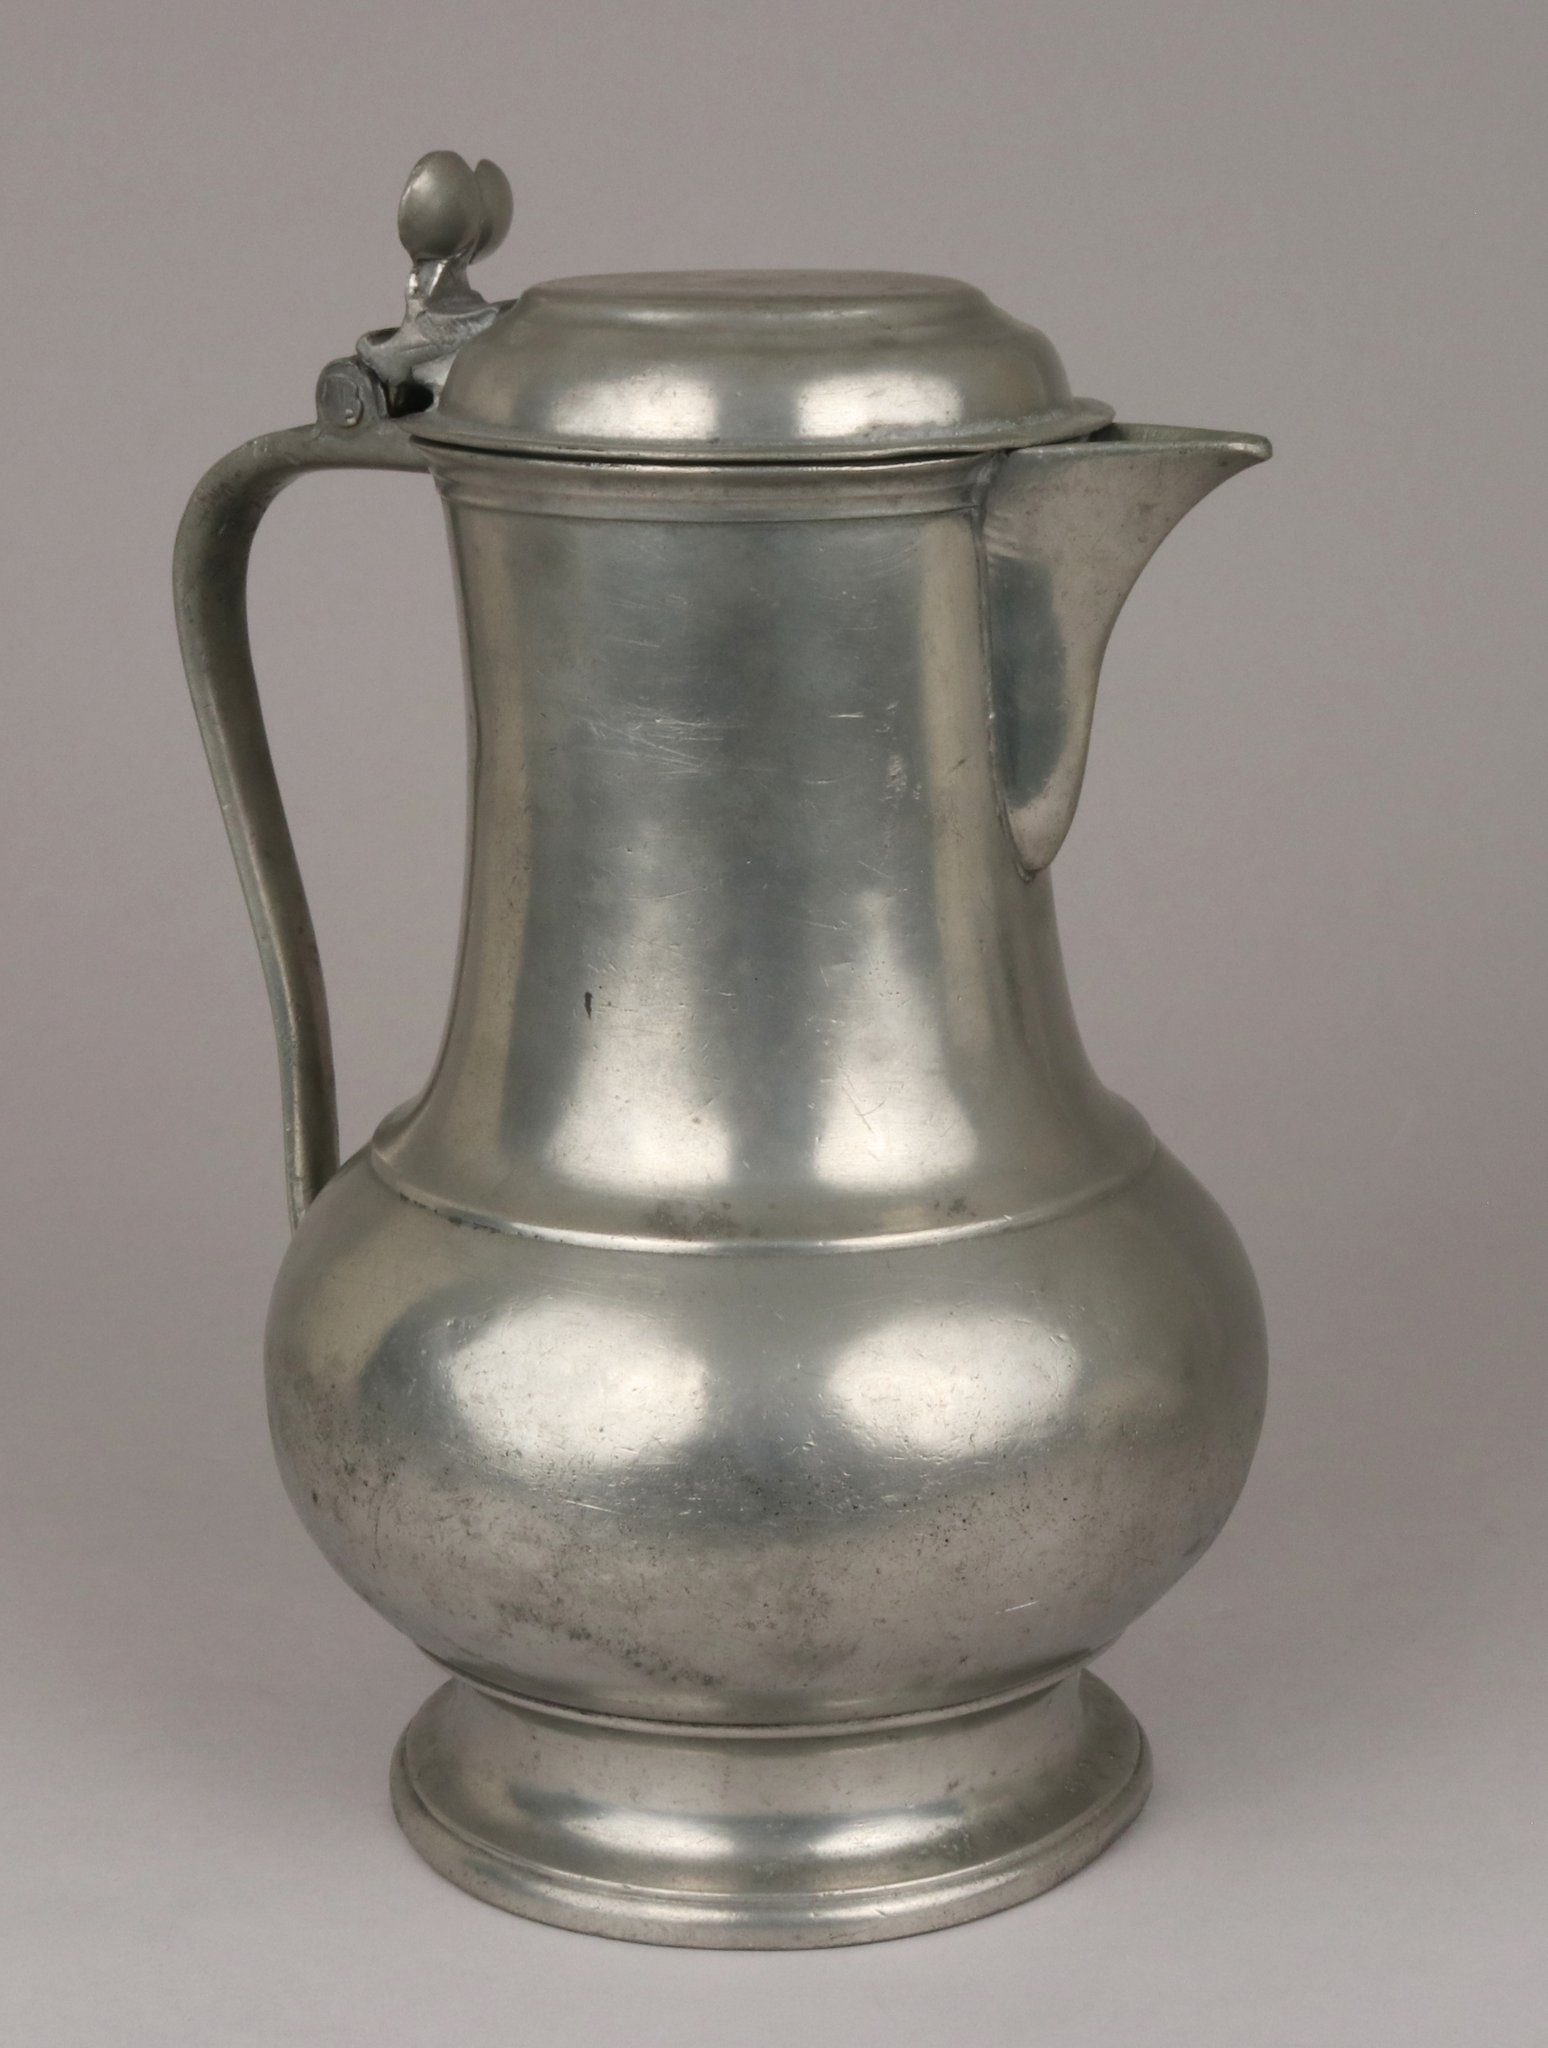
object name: flagon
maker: jacobus-mattheus vandaele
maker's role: maker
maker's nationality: flemish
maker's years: 1735-1835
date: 1701-1800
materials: pewter